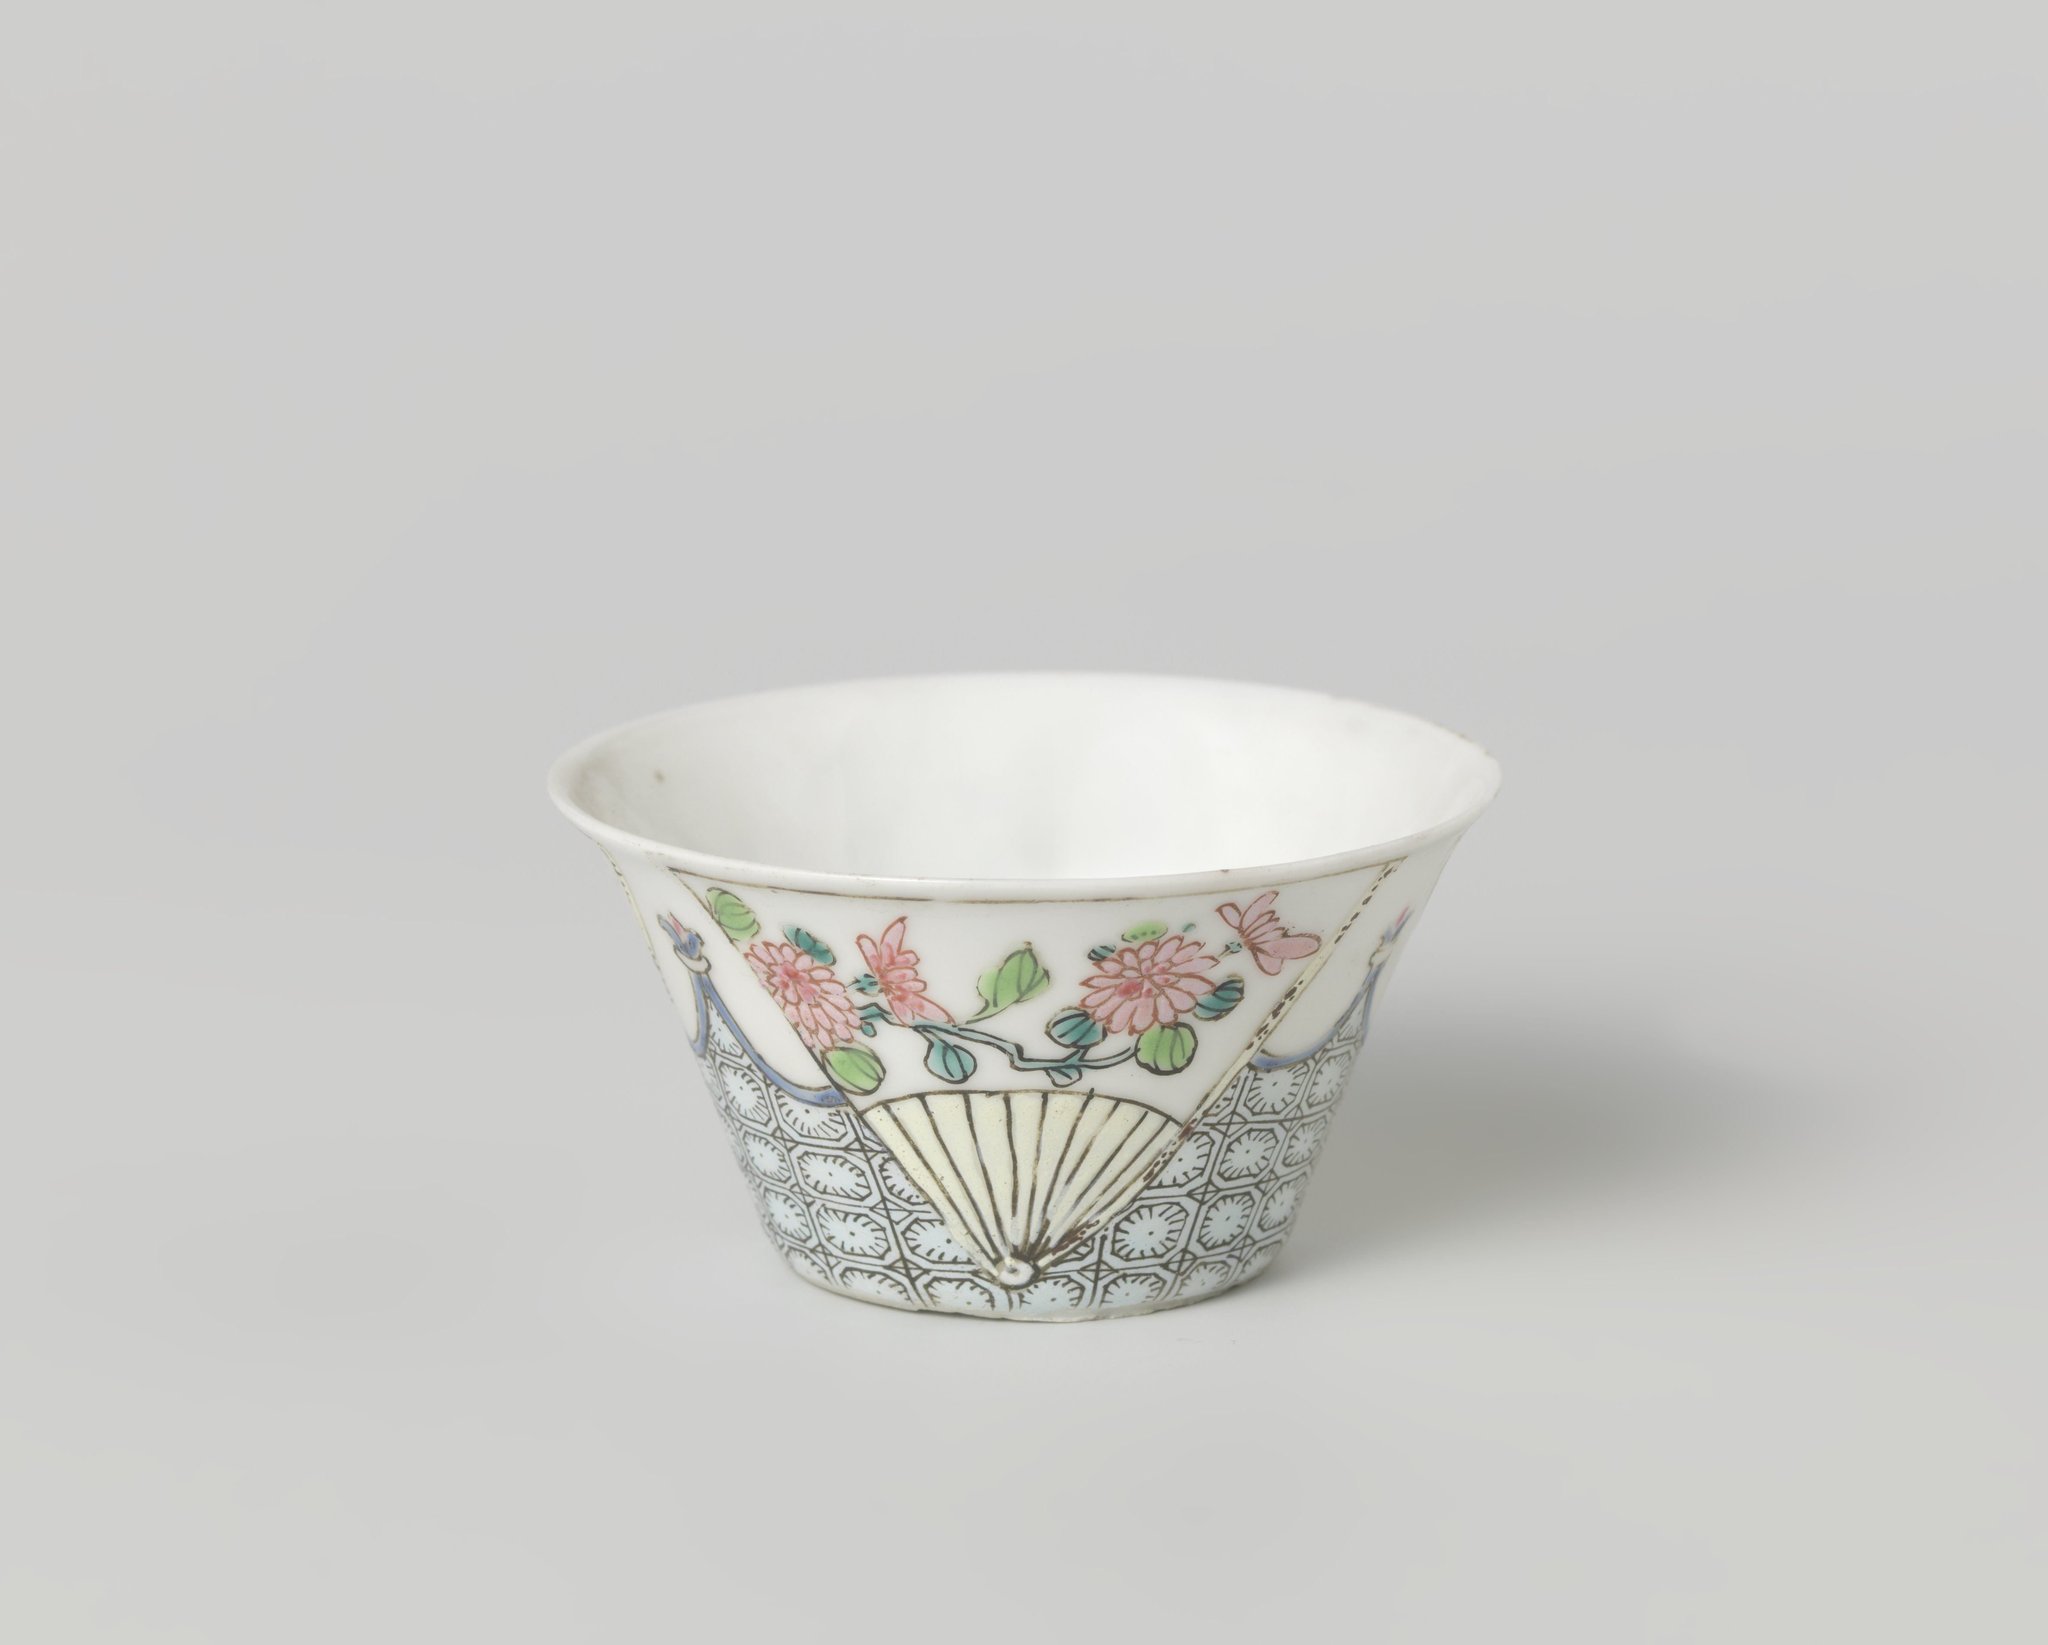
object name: cup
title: Cup with three fans with flower sprays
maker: Anonymous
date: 1725-1749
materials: glaze, paint, porcelain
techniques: firing, turning, vitrification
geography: china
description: Kop en schotel, famille rose, met waaiers en bloemen op blauwe grond.